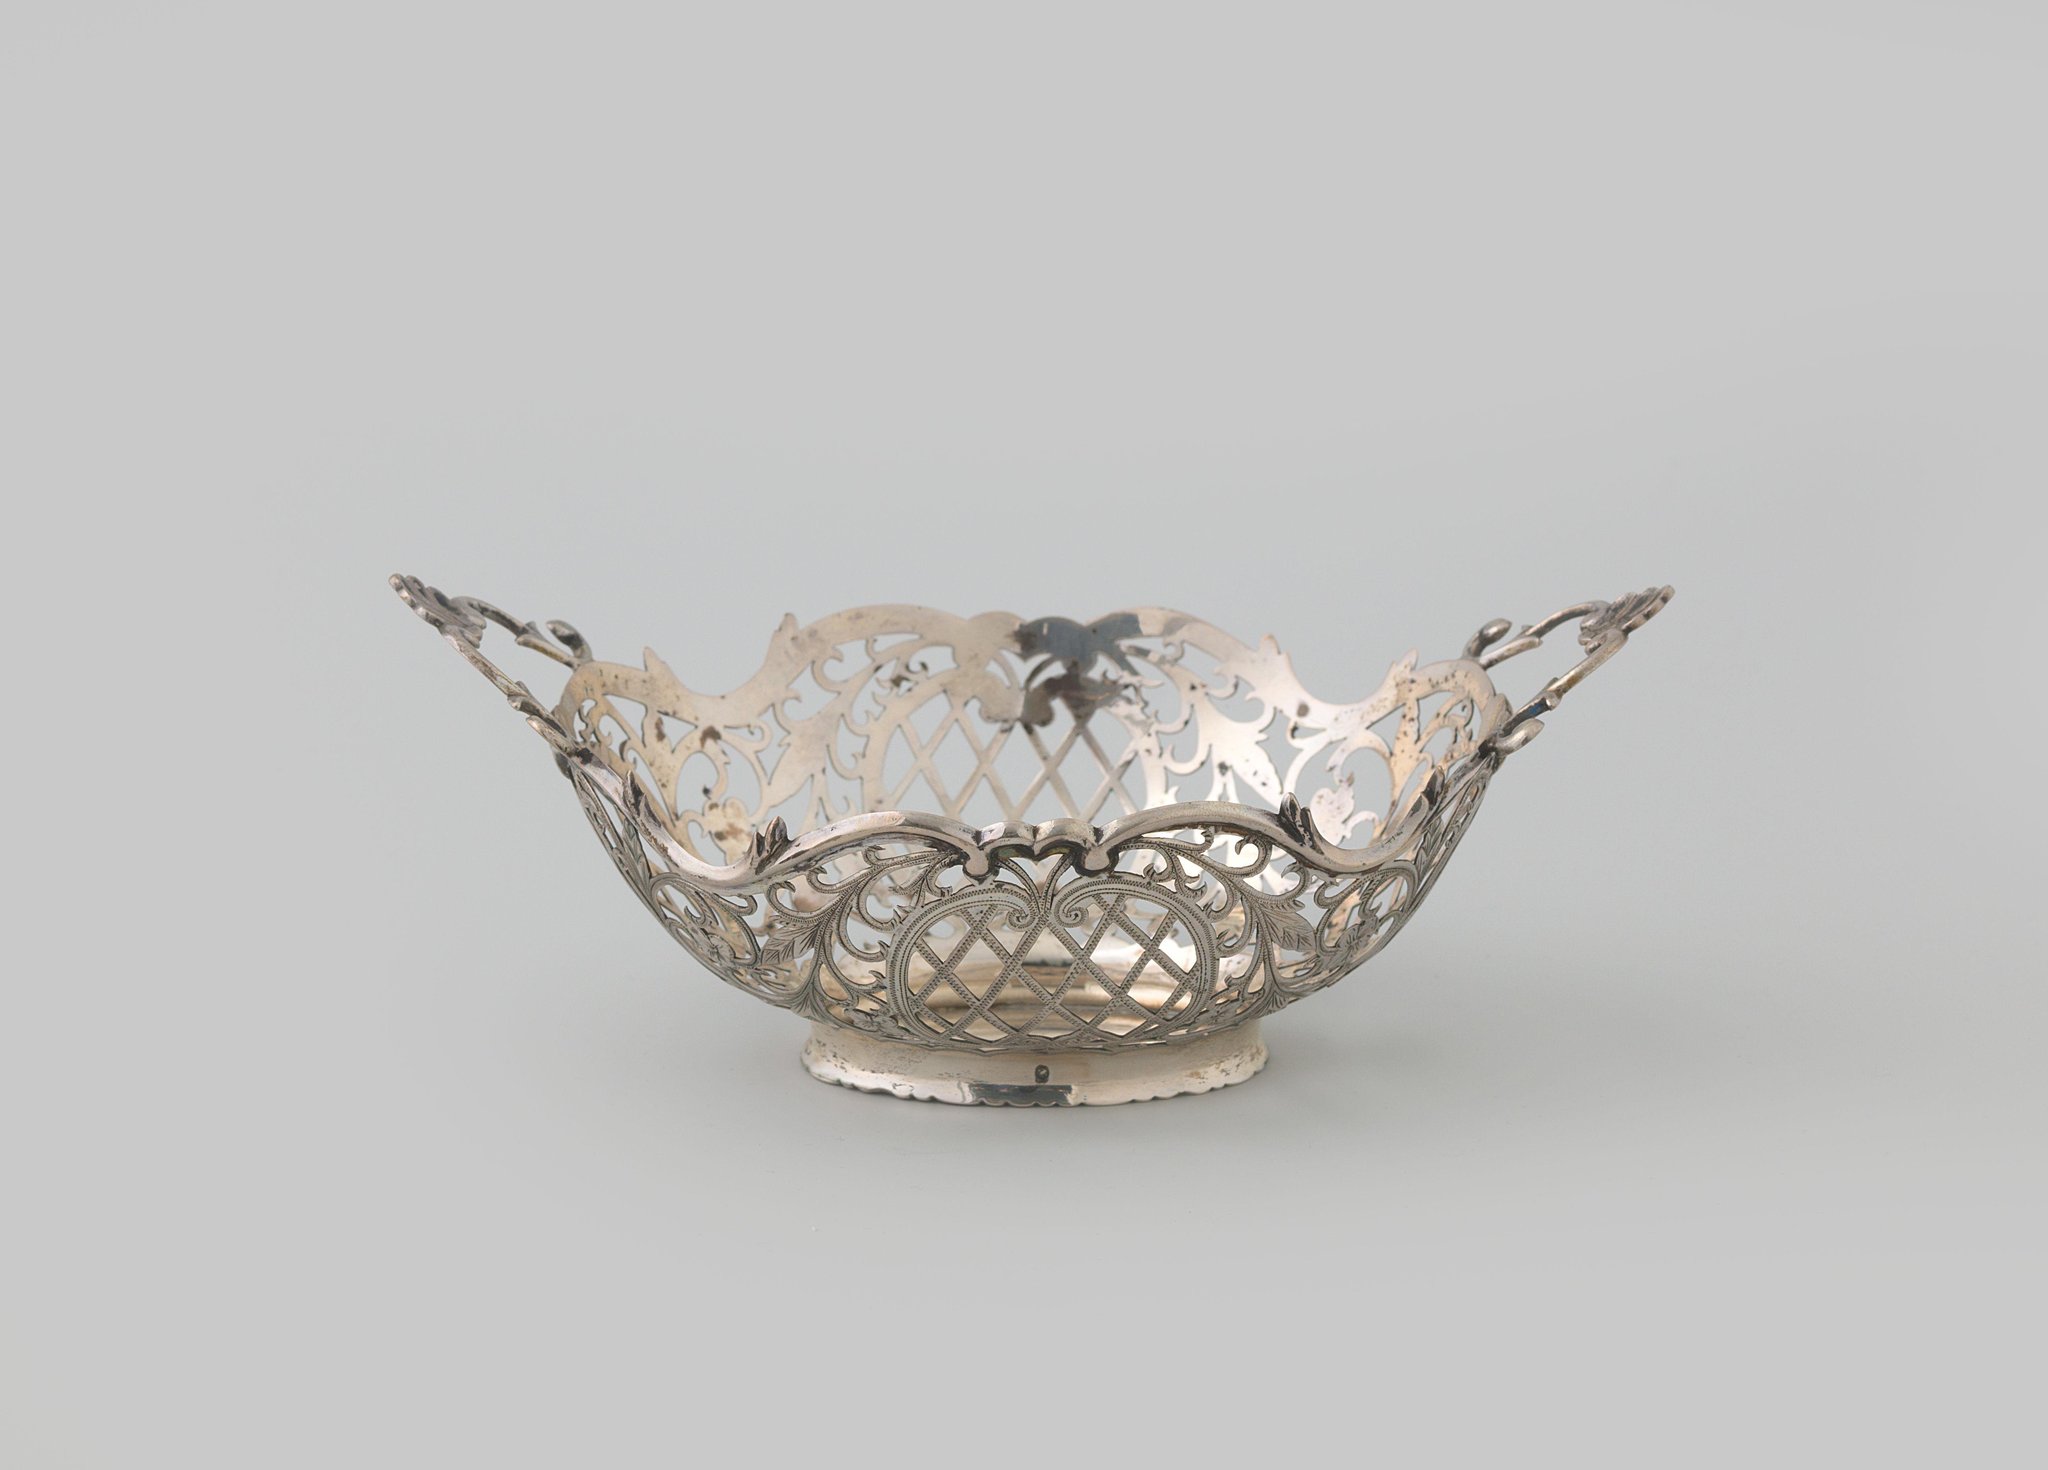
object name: bonbonmand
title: Bonbonmand van zilver, ovaal, in Lodewijk XVe stijl, met opengewerkte wand met bladmotieven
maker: gerrit greup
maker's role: silversmith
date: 1909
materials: silver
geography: schoonhoven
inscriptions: mark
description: Ovale bonbonmand van zilver, in Lodewijk XV stijl. De wand is opengewerkt met bladmotieven.